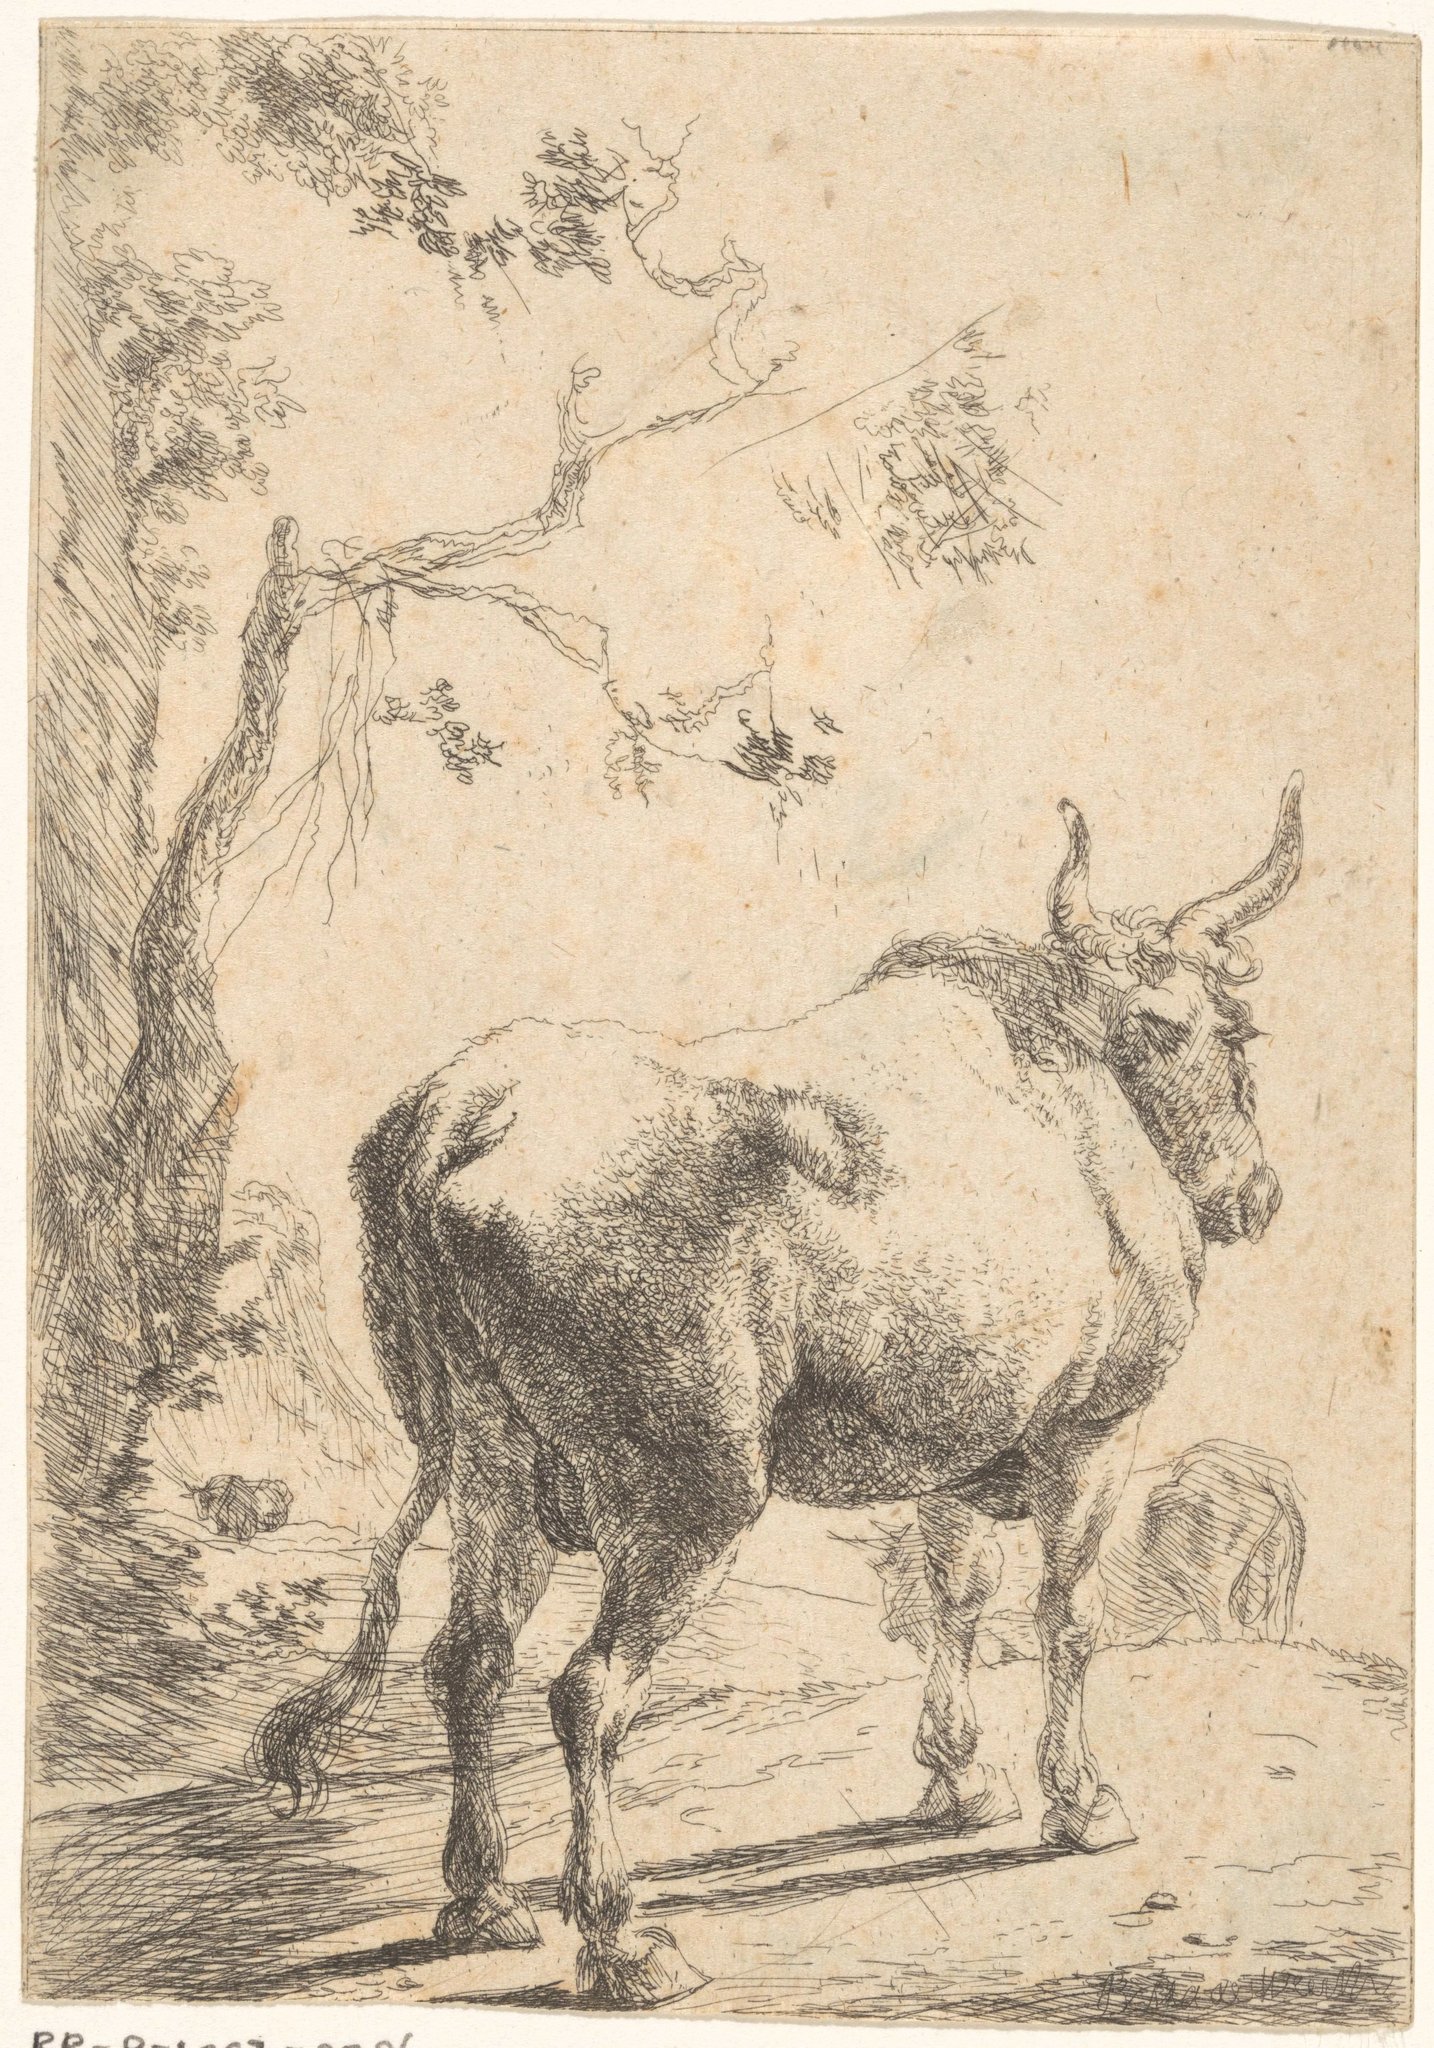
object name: print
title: Stier met twee koeien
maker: jan baptist weenix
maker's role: draughtsman, painter, print maker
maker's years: 1621-1661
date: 1647-1659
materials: paper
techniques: etching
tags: trees, bull, cow, landscapes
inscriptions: collector's mark: Lugt 68, collector's mark: Lugt 2228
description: In een landschap met een boom staat een stier. Achter de stier zijn twee koeien te zien.